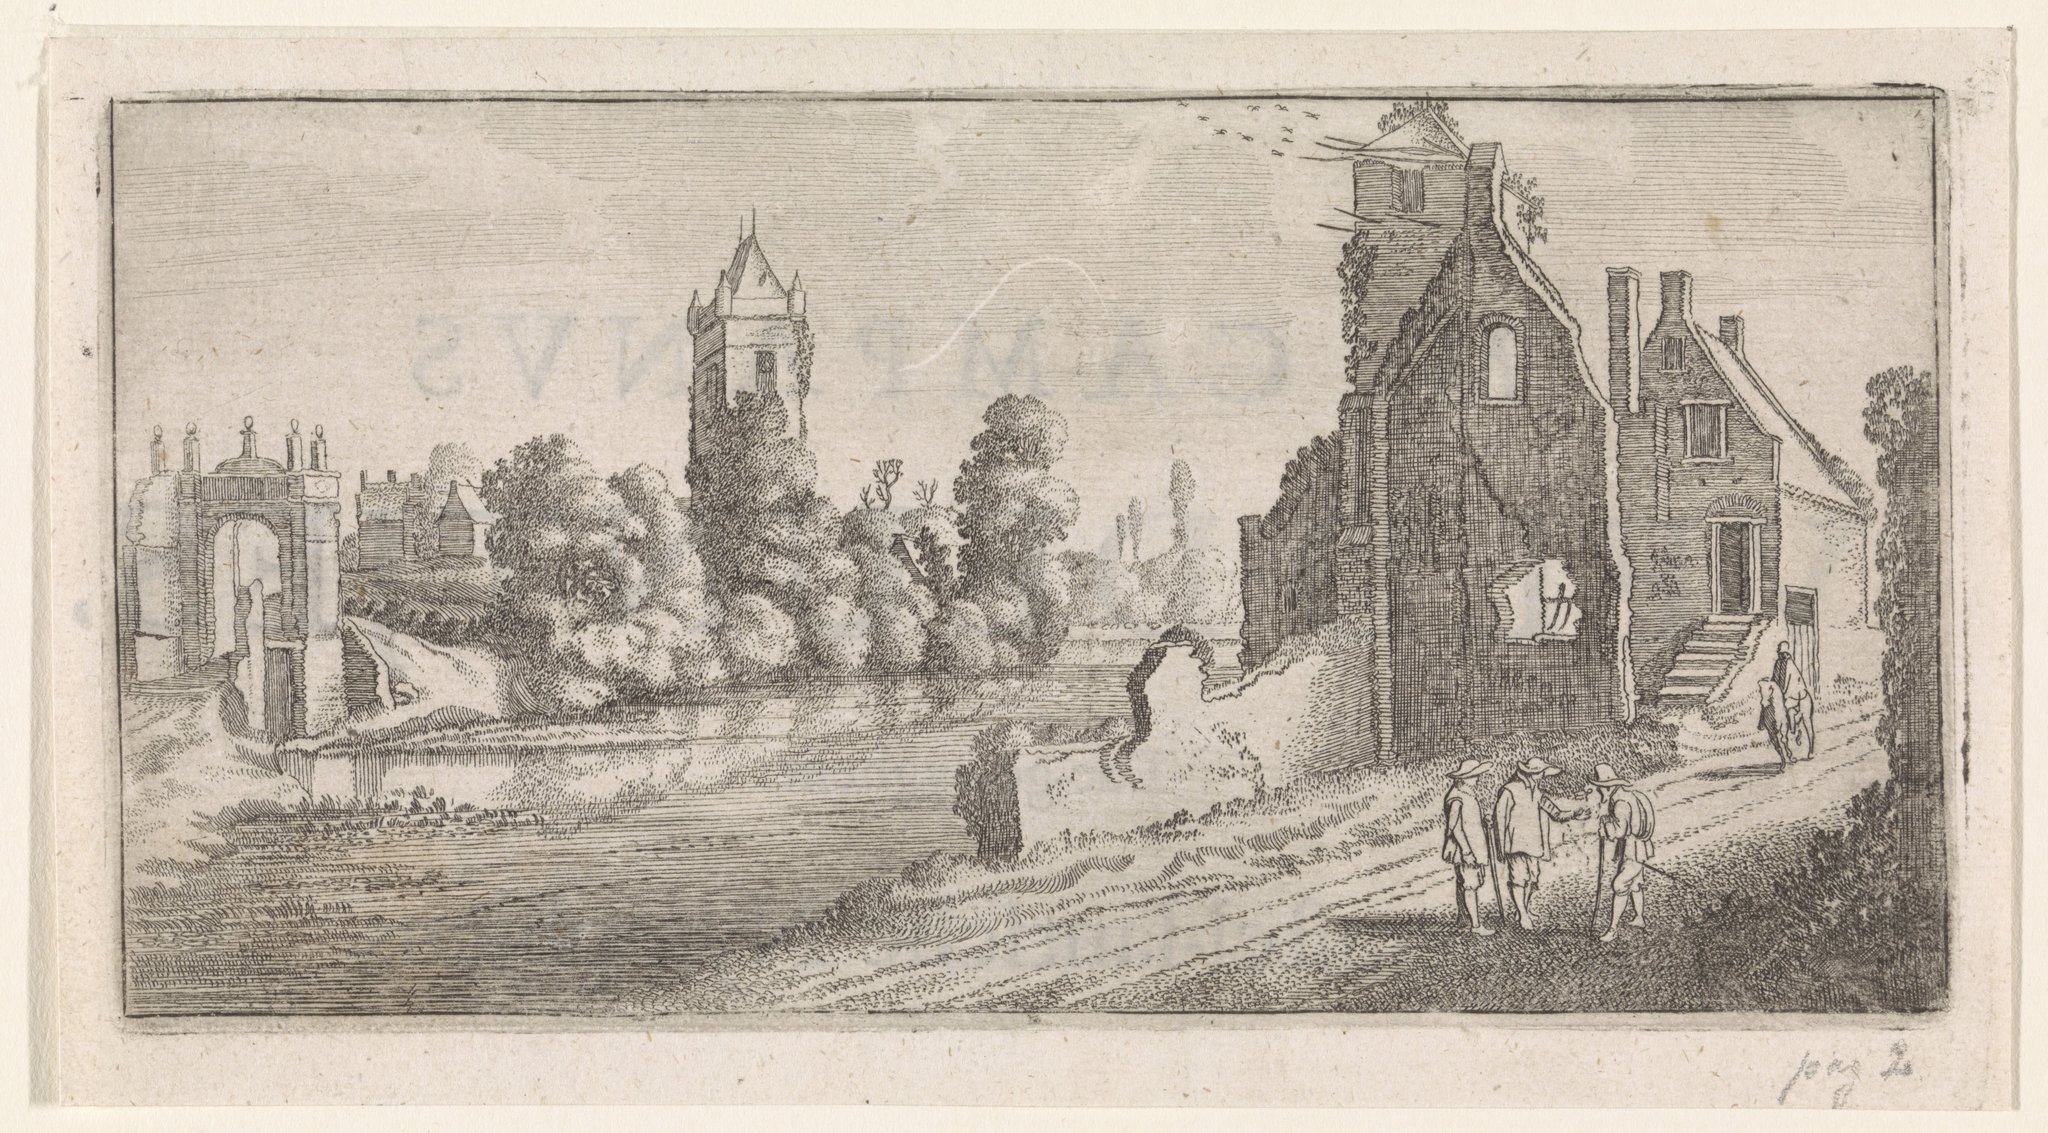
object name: book illustration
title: Figuren in een rivierlandschap met ruïnes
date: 1627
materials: paper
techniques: etching, letterpress printing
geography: amsterdam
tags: river, landscape with ruins, gate, entrance, landscape with tower or castle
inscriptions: collector's mark: Lugt 964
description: Boekillustratie in: Campanus, M., Colevelt, J.J. Craen, A.P., Robbertzen, J. Amsterdamsche Pegasus, waer in (uyt lust) byeen vergadert zijn veel minnelycke liedekens. Amsterdam: Cornelis Willemsz Blaeu-laken, 1627.